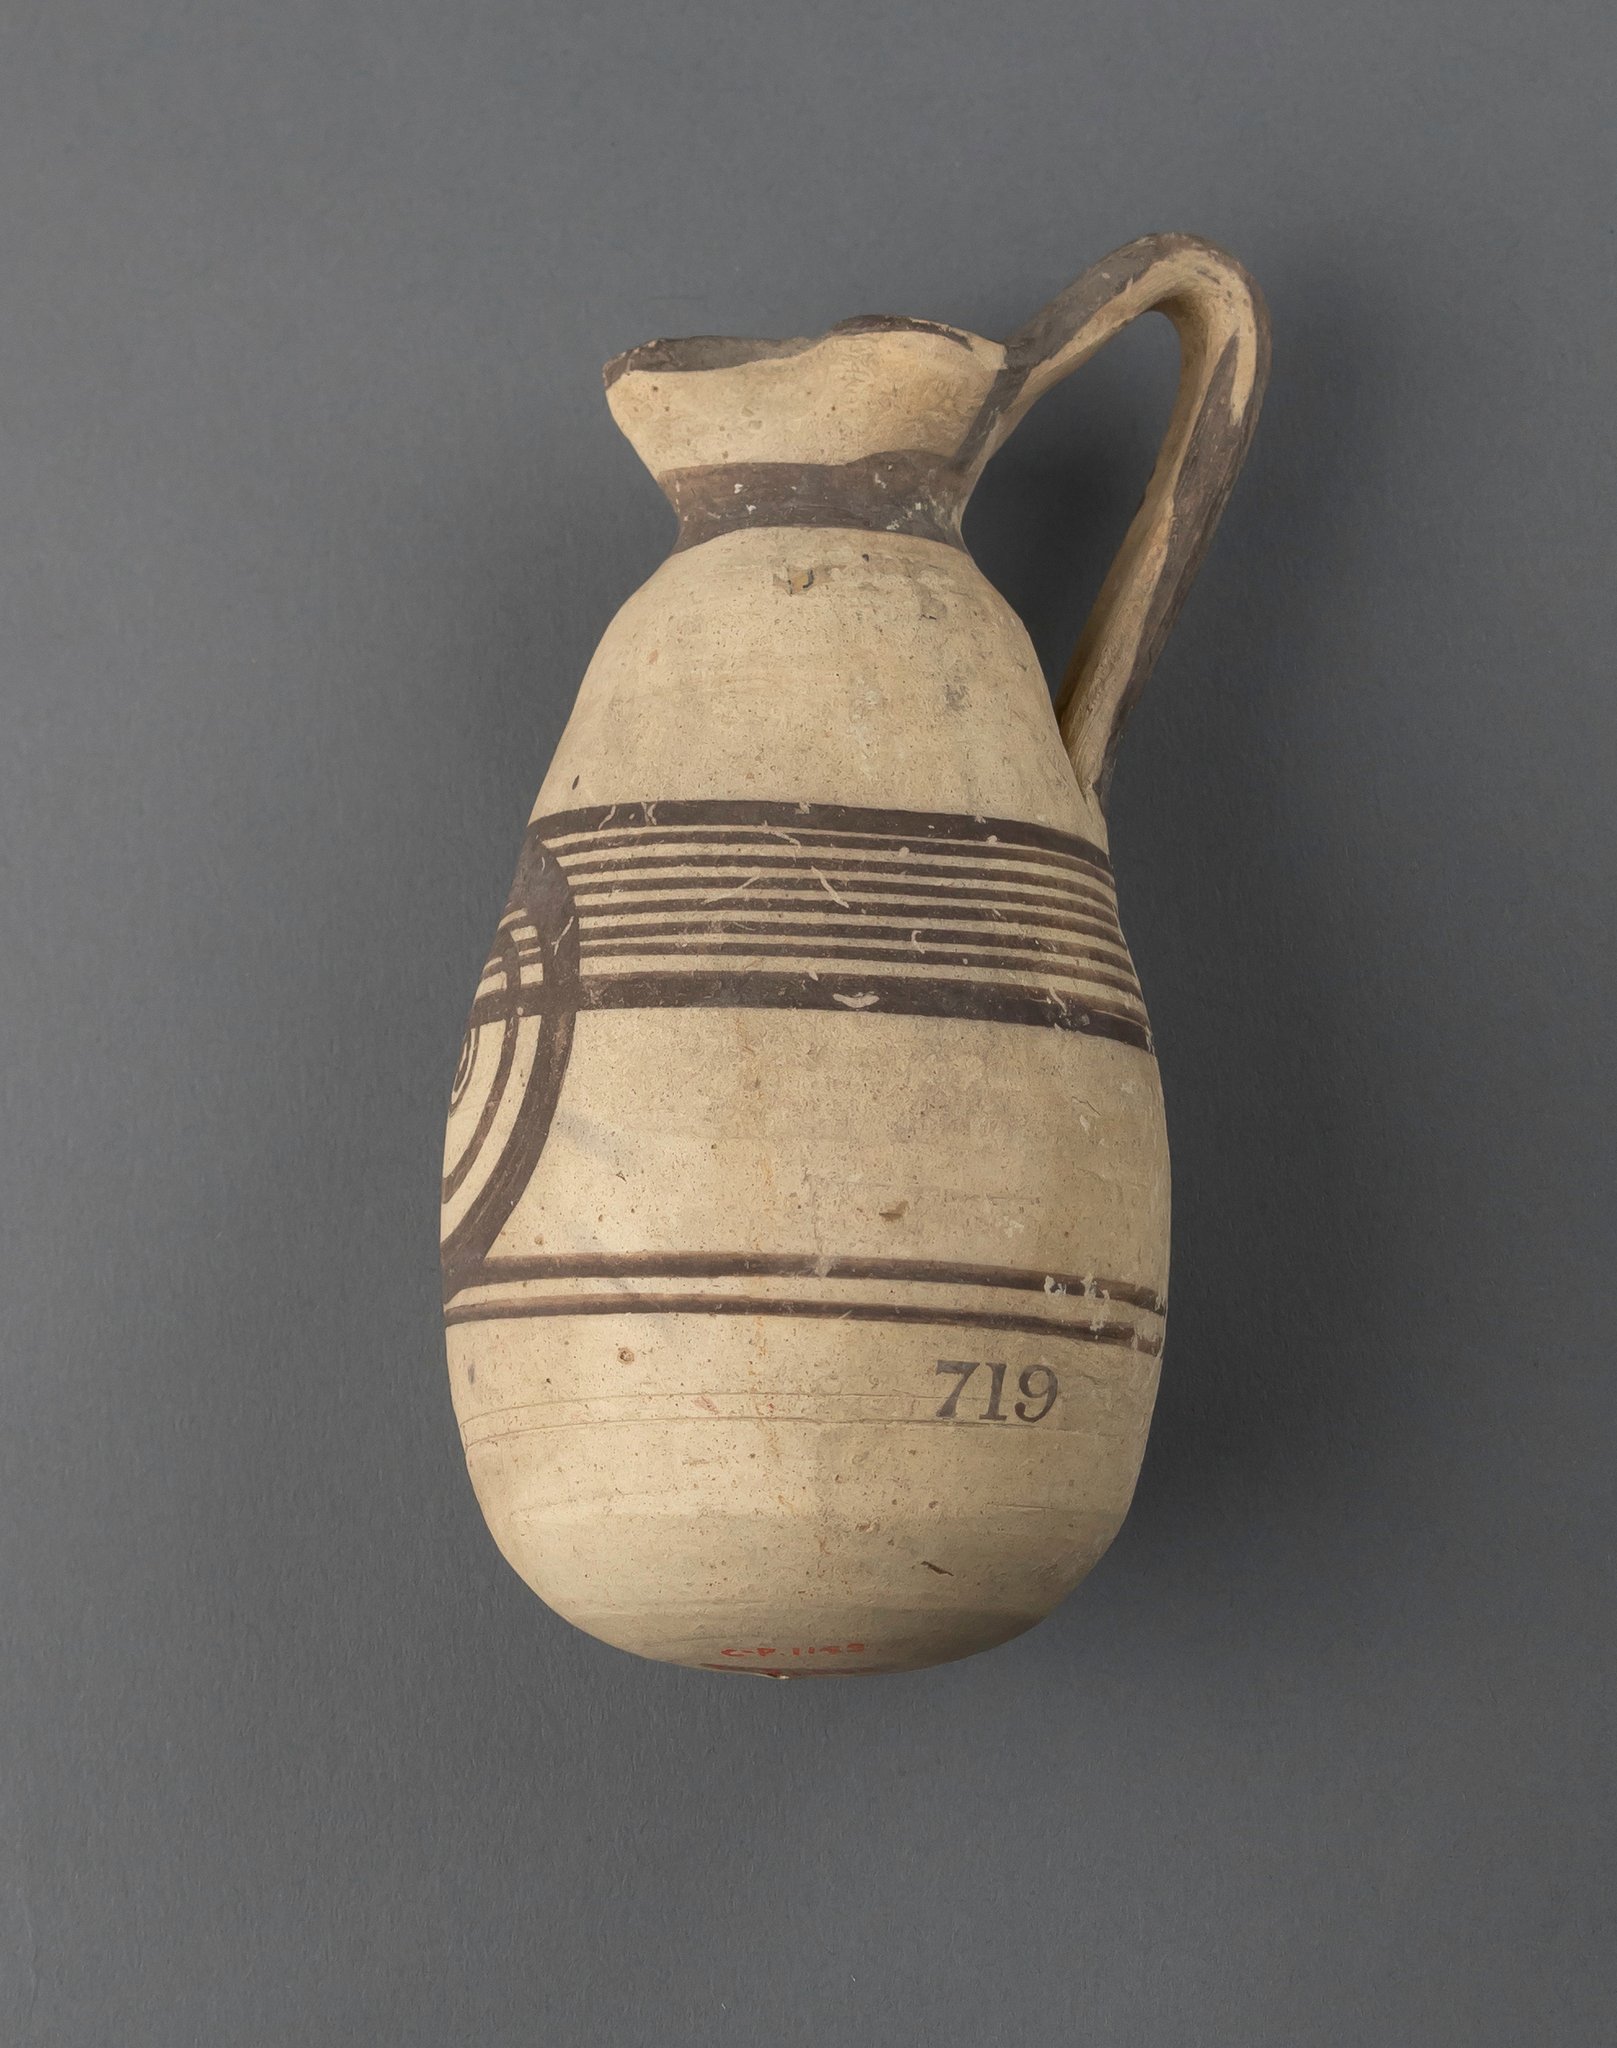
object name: oinochoe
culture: cypriot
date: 1050-900 BCE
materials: terracotta